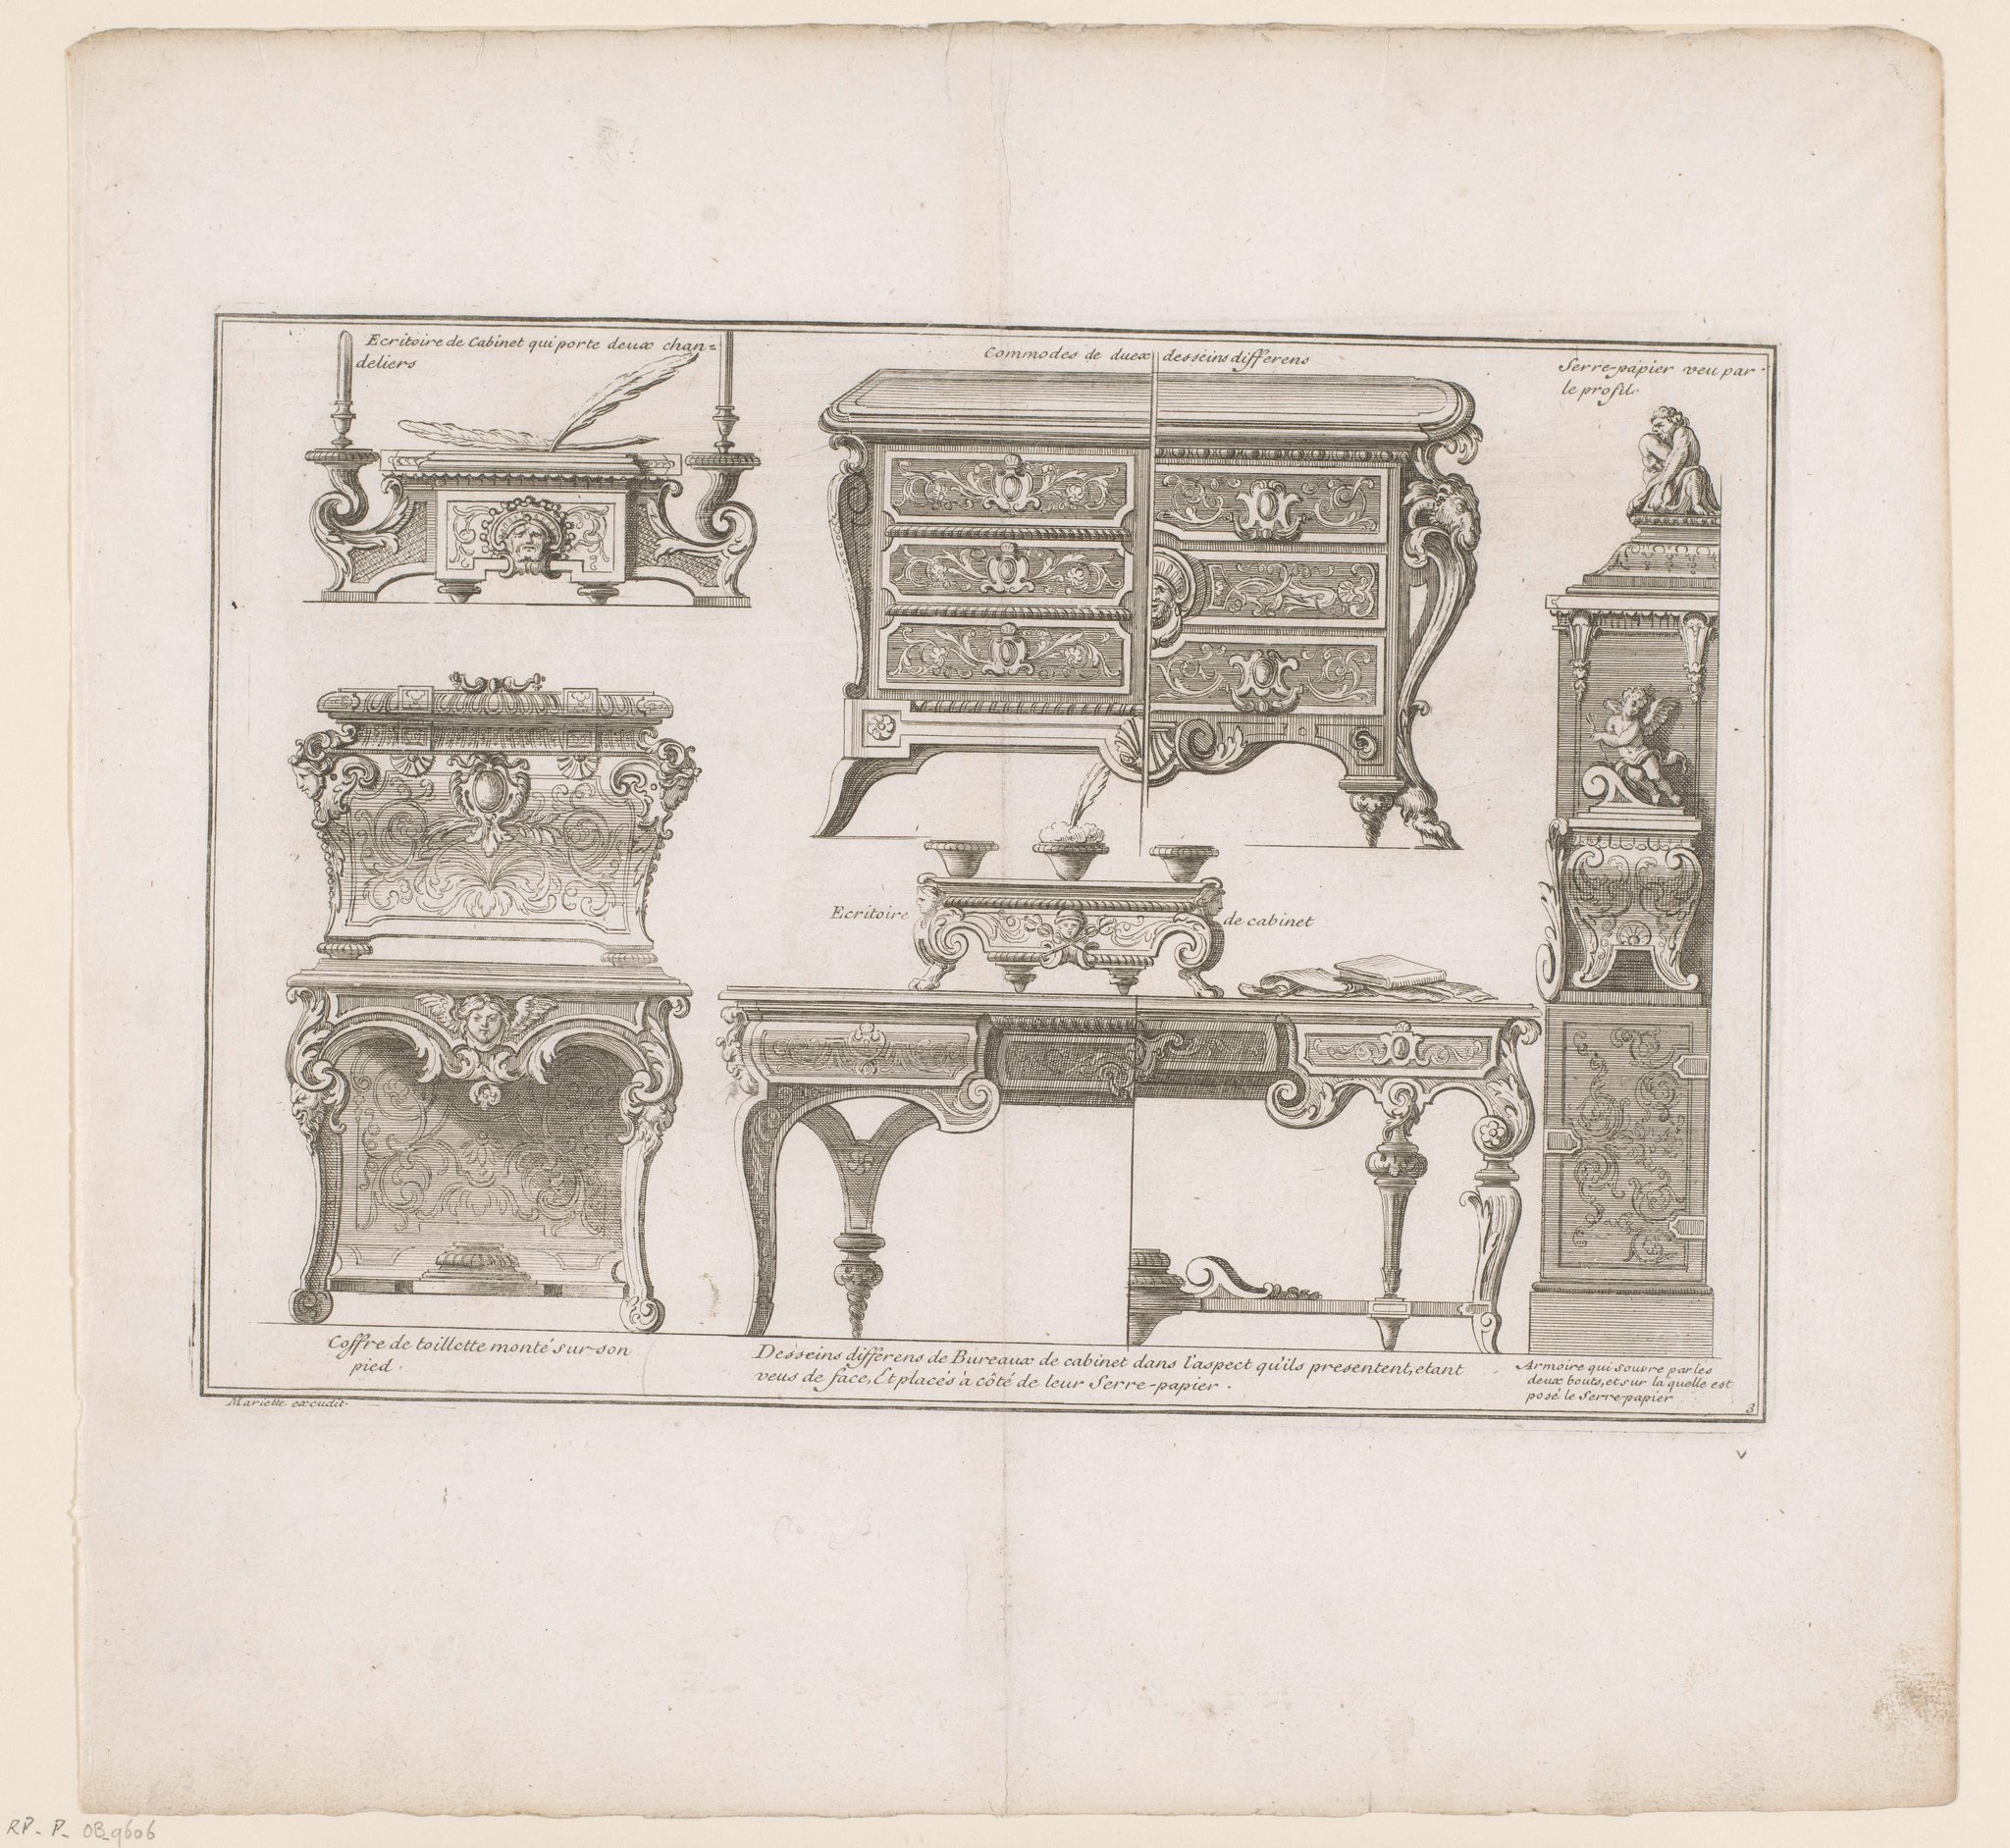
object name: print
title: Deisseins differens de Bureaux de cabinet (...)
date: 1710-1720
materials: paper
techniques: etching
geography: paris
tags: table, furniture and household effects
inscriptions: collector's mark: Lugt 2228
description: Links boven een schrijftafel met kandelaars. Midden boven een commode. Links onder een toilettafel. Midden onder een schrijftafel. Rechts een zijaanzicht van een opbergkast voor papier. Met Franse bijschriften.